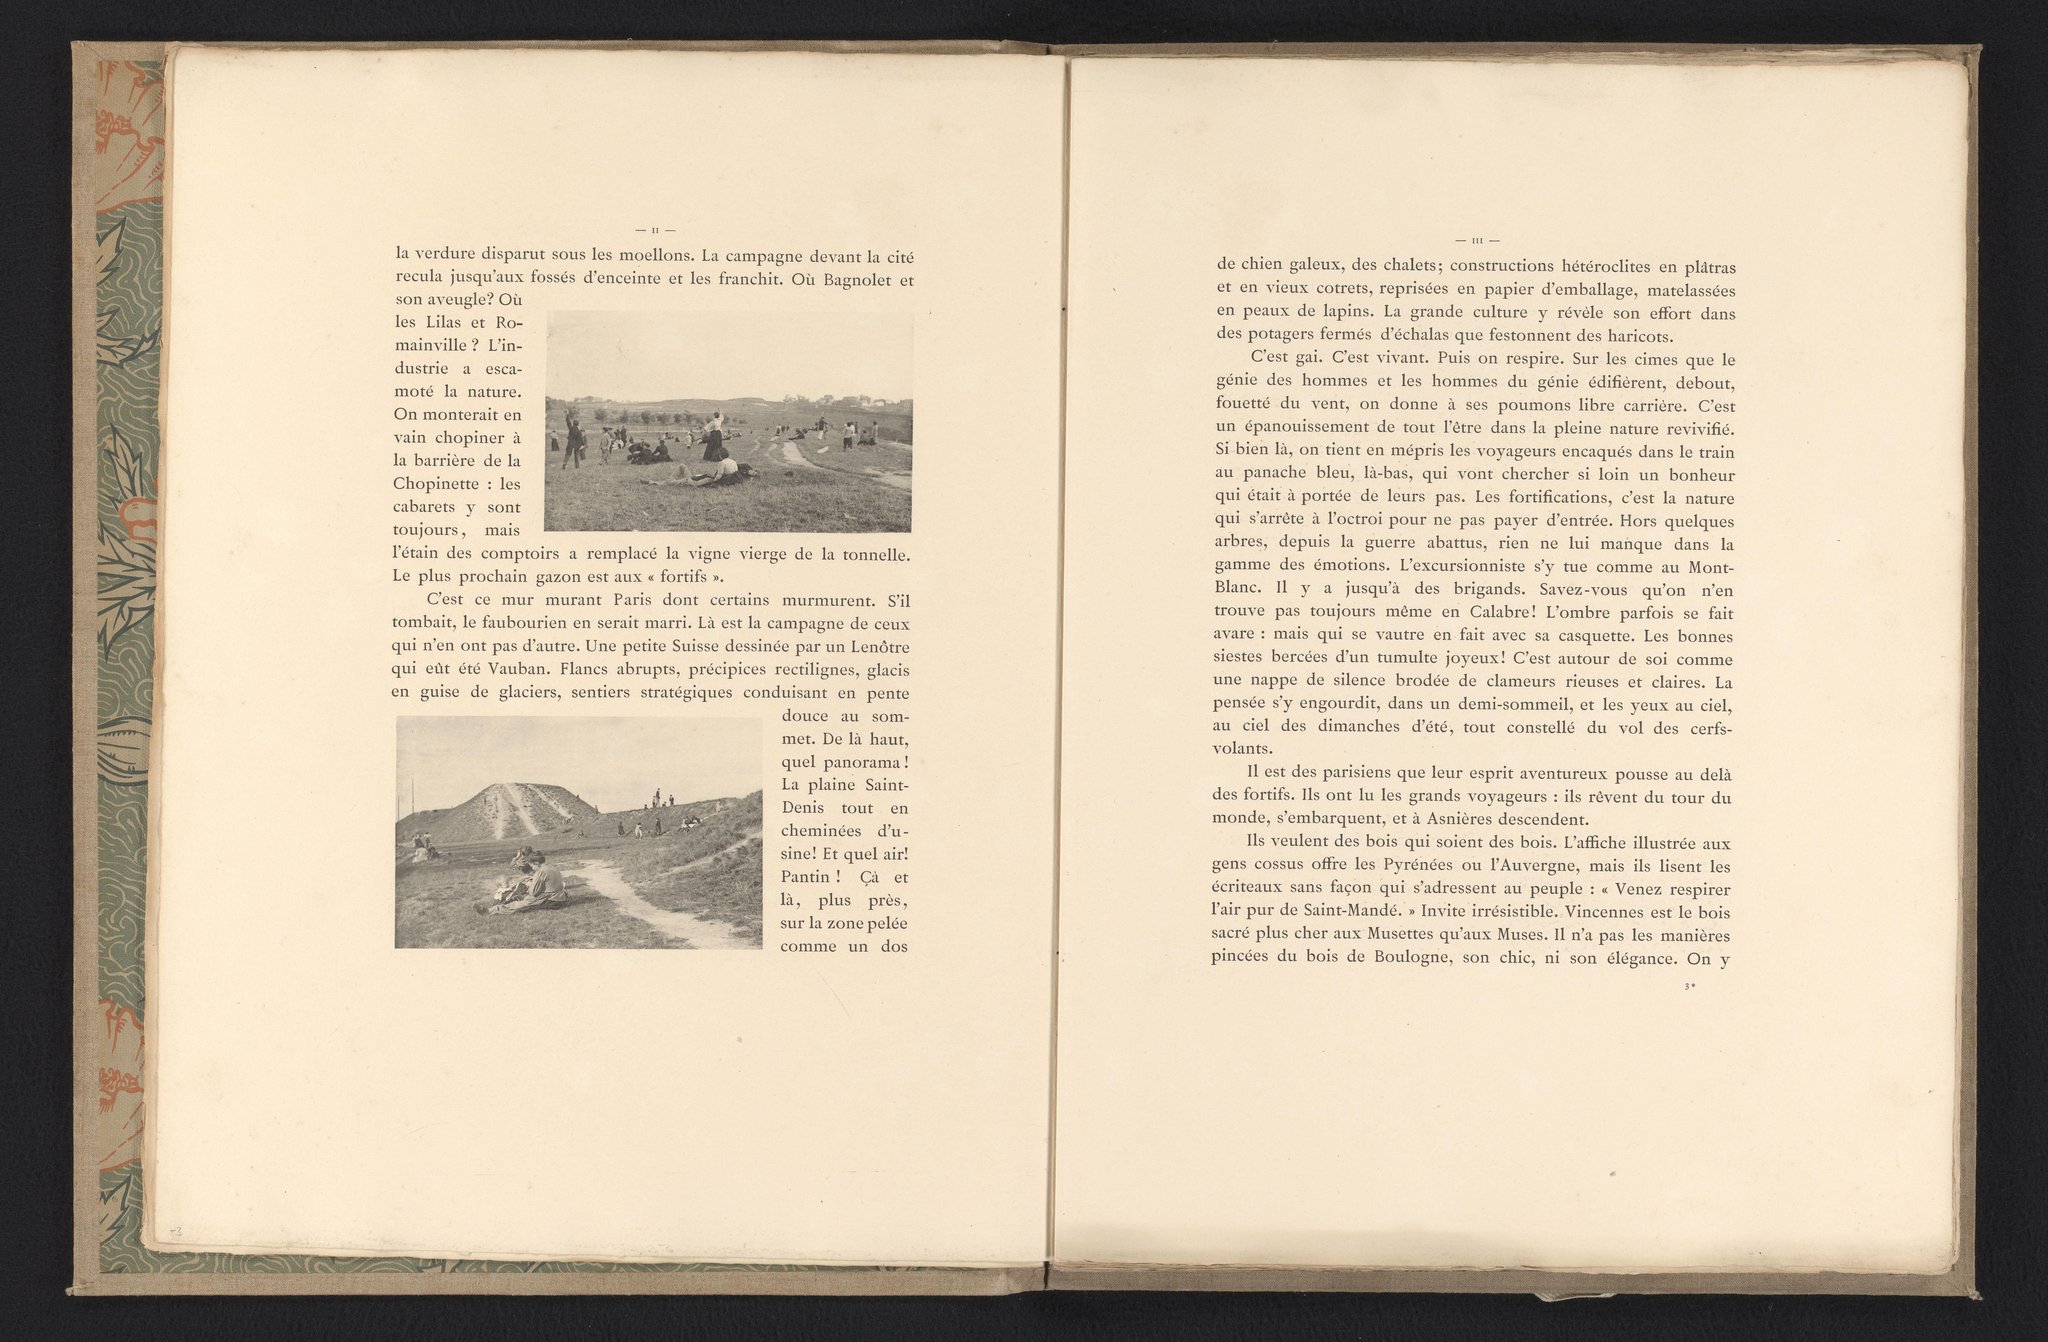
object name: photomechanical print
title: Luierende Parijzenaren op een grasveld buiten de stad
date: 1896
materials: paper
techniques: photograph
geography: paris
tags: enjoying nature